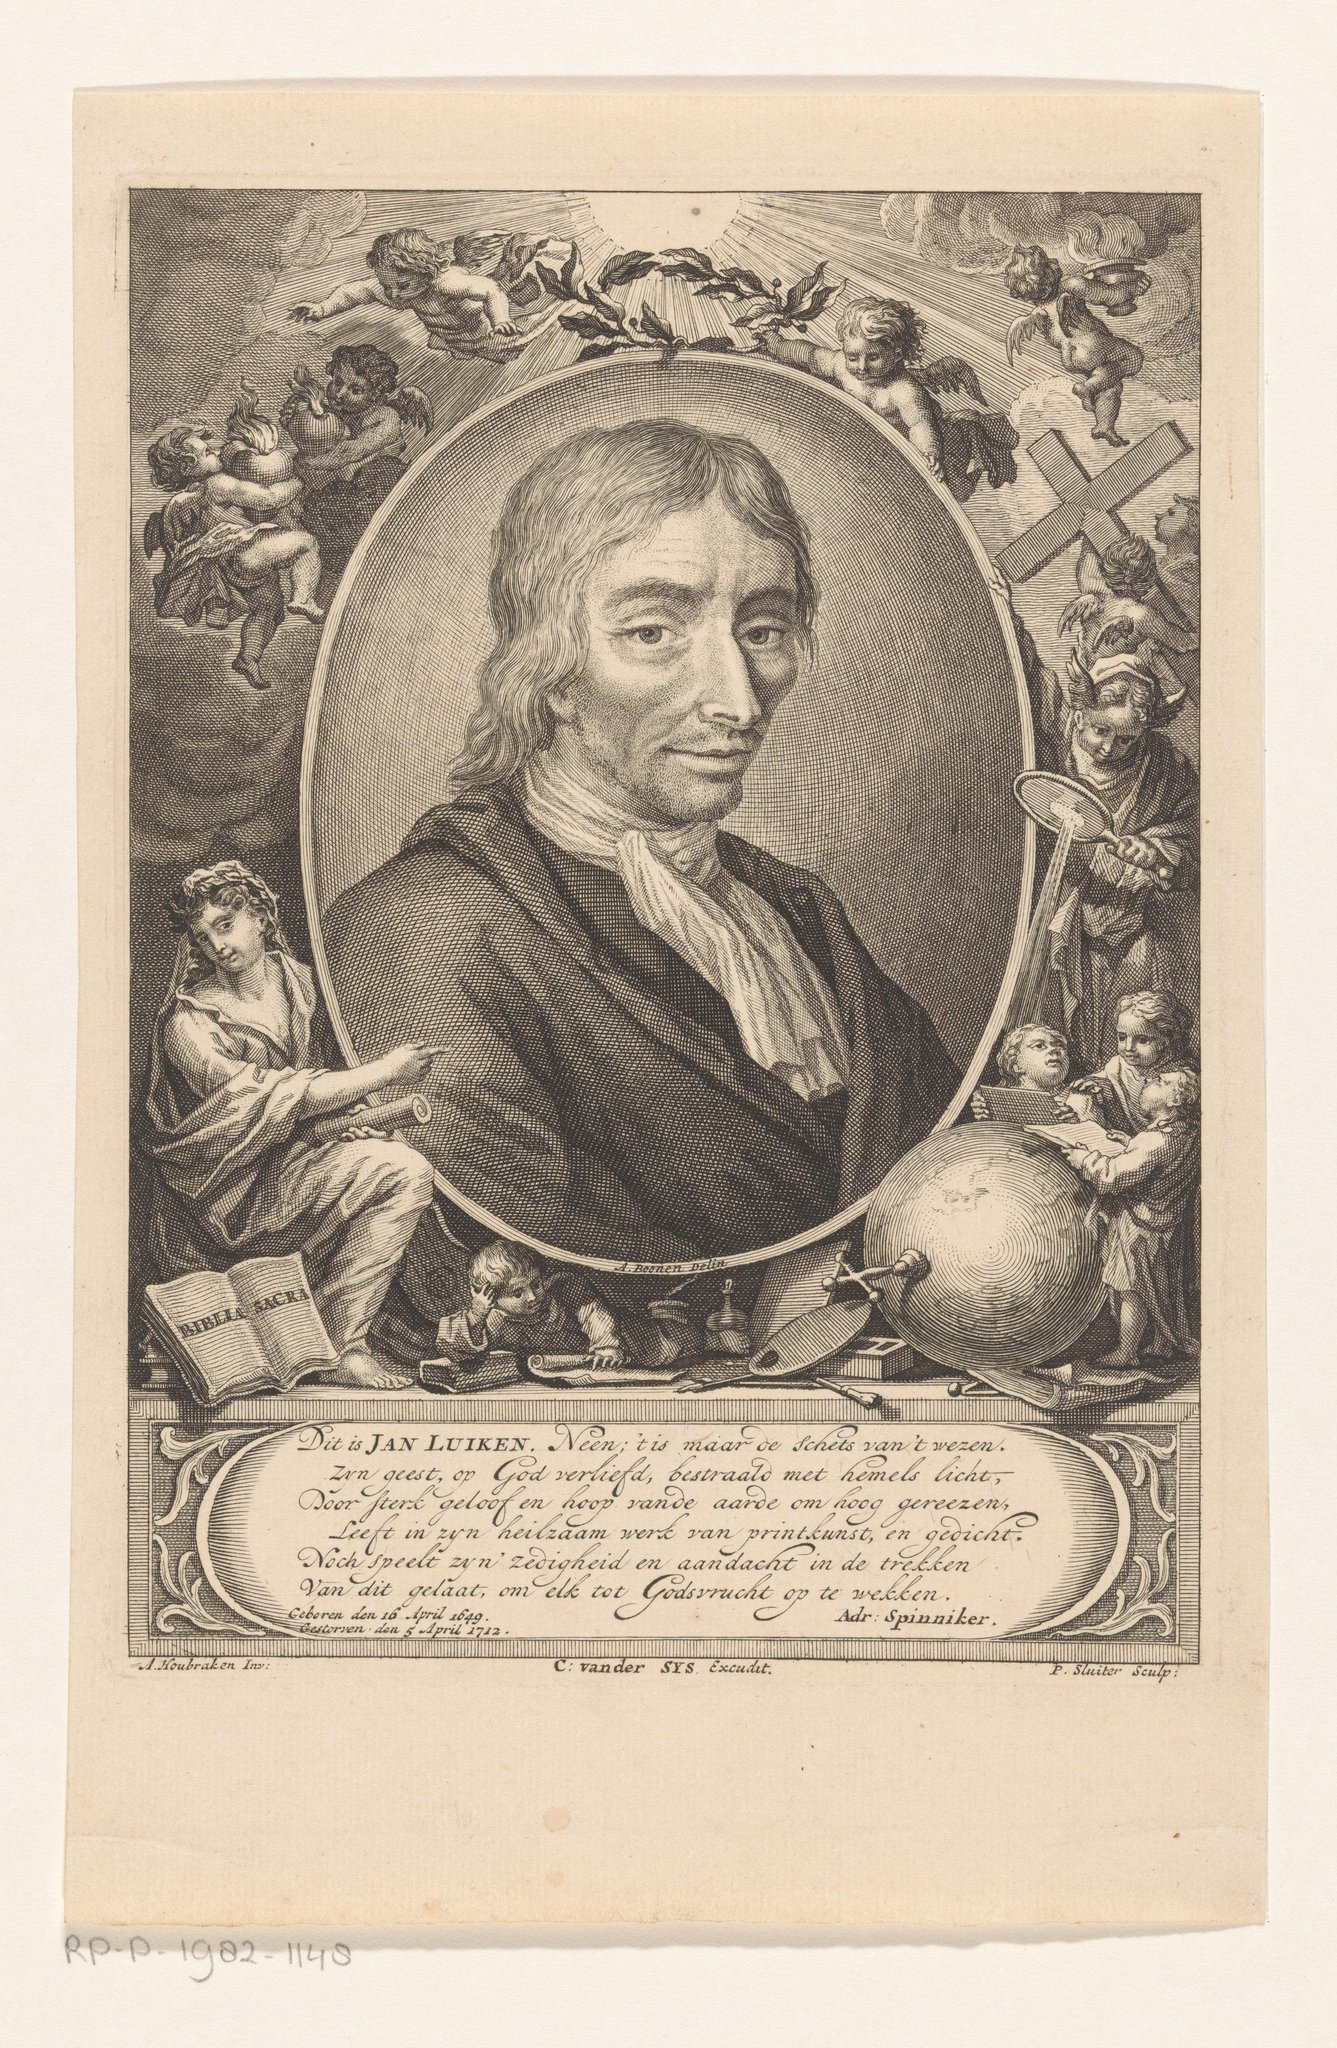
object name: print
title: Portret van Jan Luyken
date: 1712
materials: paper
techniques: engraving, etching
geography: amsterdam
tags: amsterdam, draughtsman, jan luyken, orb (symbol of sovereignty; sphere with cross on top), cross as symbol of christ, the sacred heart, portrait, self-portrait of graphic artist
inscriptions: collector's mark: Lugt 2760, collector's mark: Lugt 2228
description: Portret van de prentmaker, schilder en dichter Jan Luyken. Boven het ovaal met het portret houdt een putto een lauwerkrans vast. Andere putti dragen een kruis, wierookvat of brandende harten. Op de grond ligt een rijksappel waarbij lezende kinderen staan, die afgeleid worden door een figuur met een gevleugeld hoofddeksel, mogelijk Mercurius. Deze laat door een vergrootglas zonlicht vallen op het tafereel onder hem. Op de grond liggen teken- en schildersbenodigdheden, boeken en een bijbel. Een vrouw met een boekrol in de hand wijst op het portret. In een cartouche de geboorte- en sterfdatum van Luyken en een lofdicht in het Nederlands.